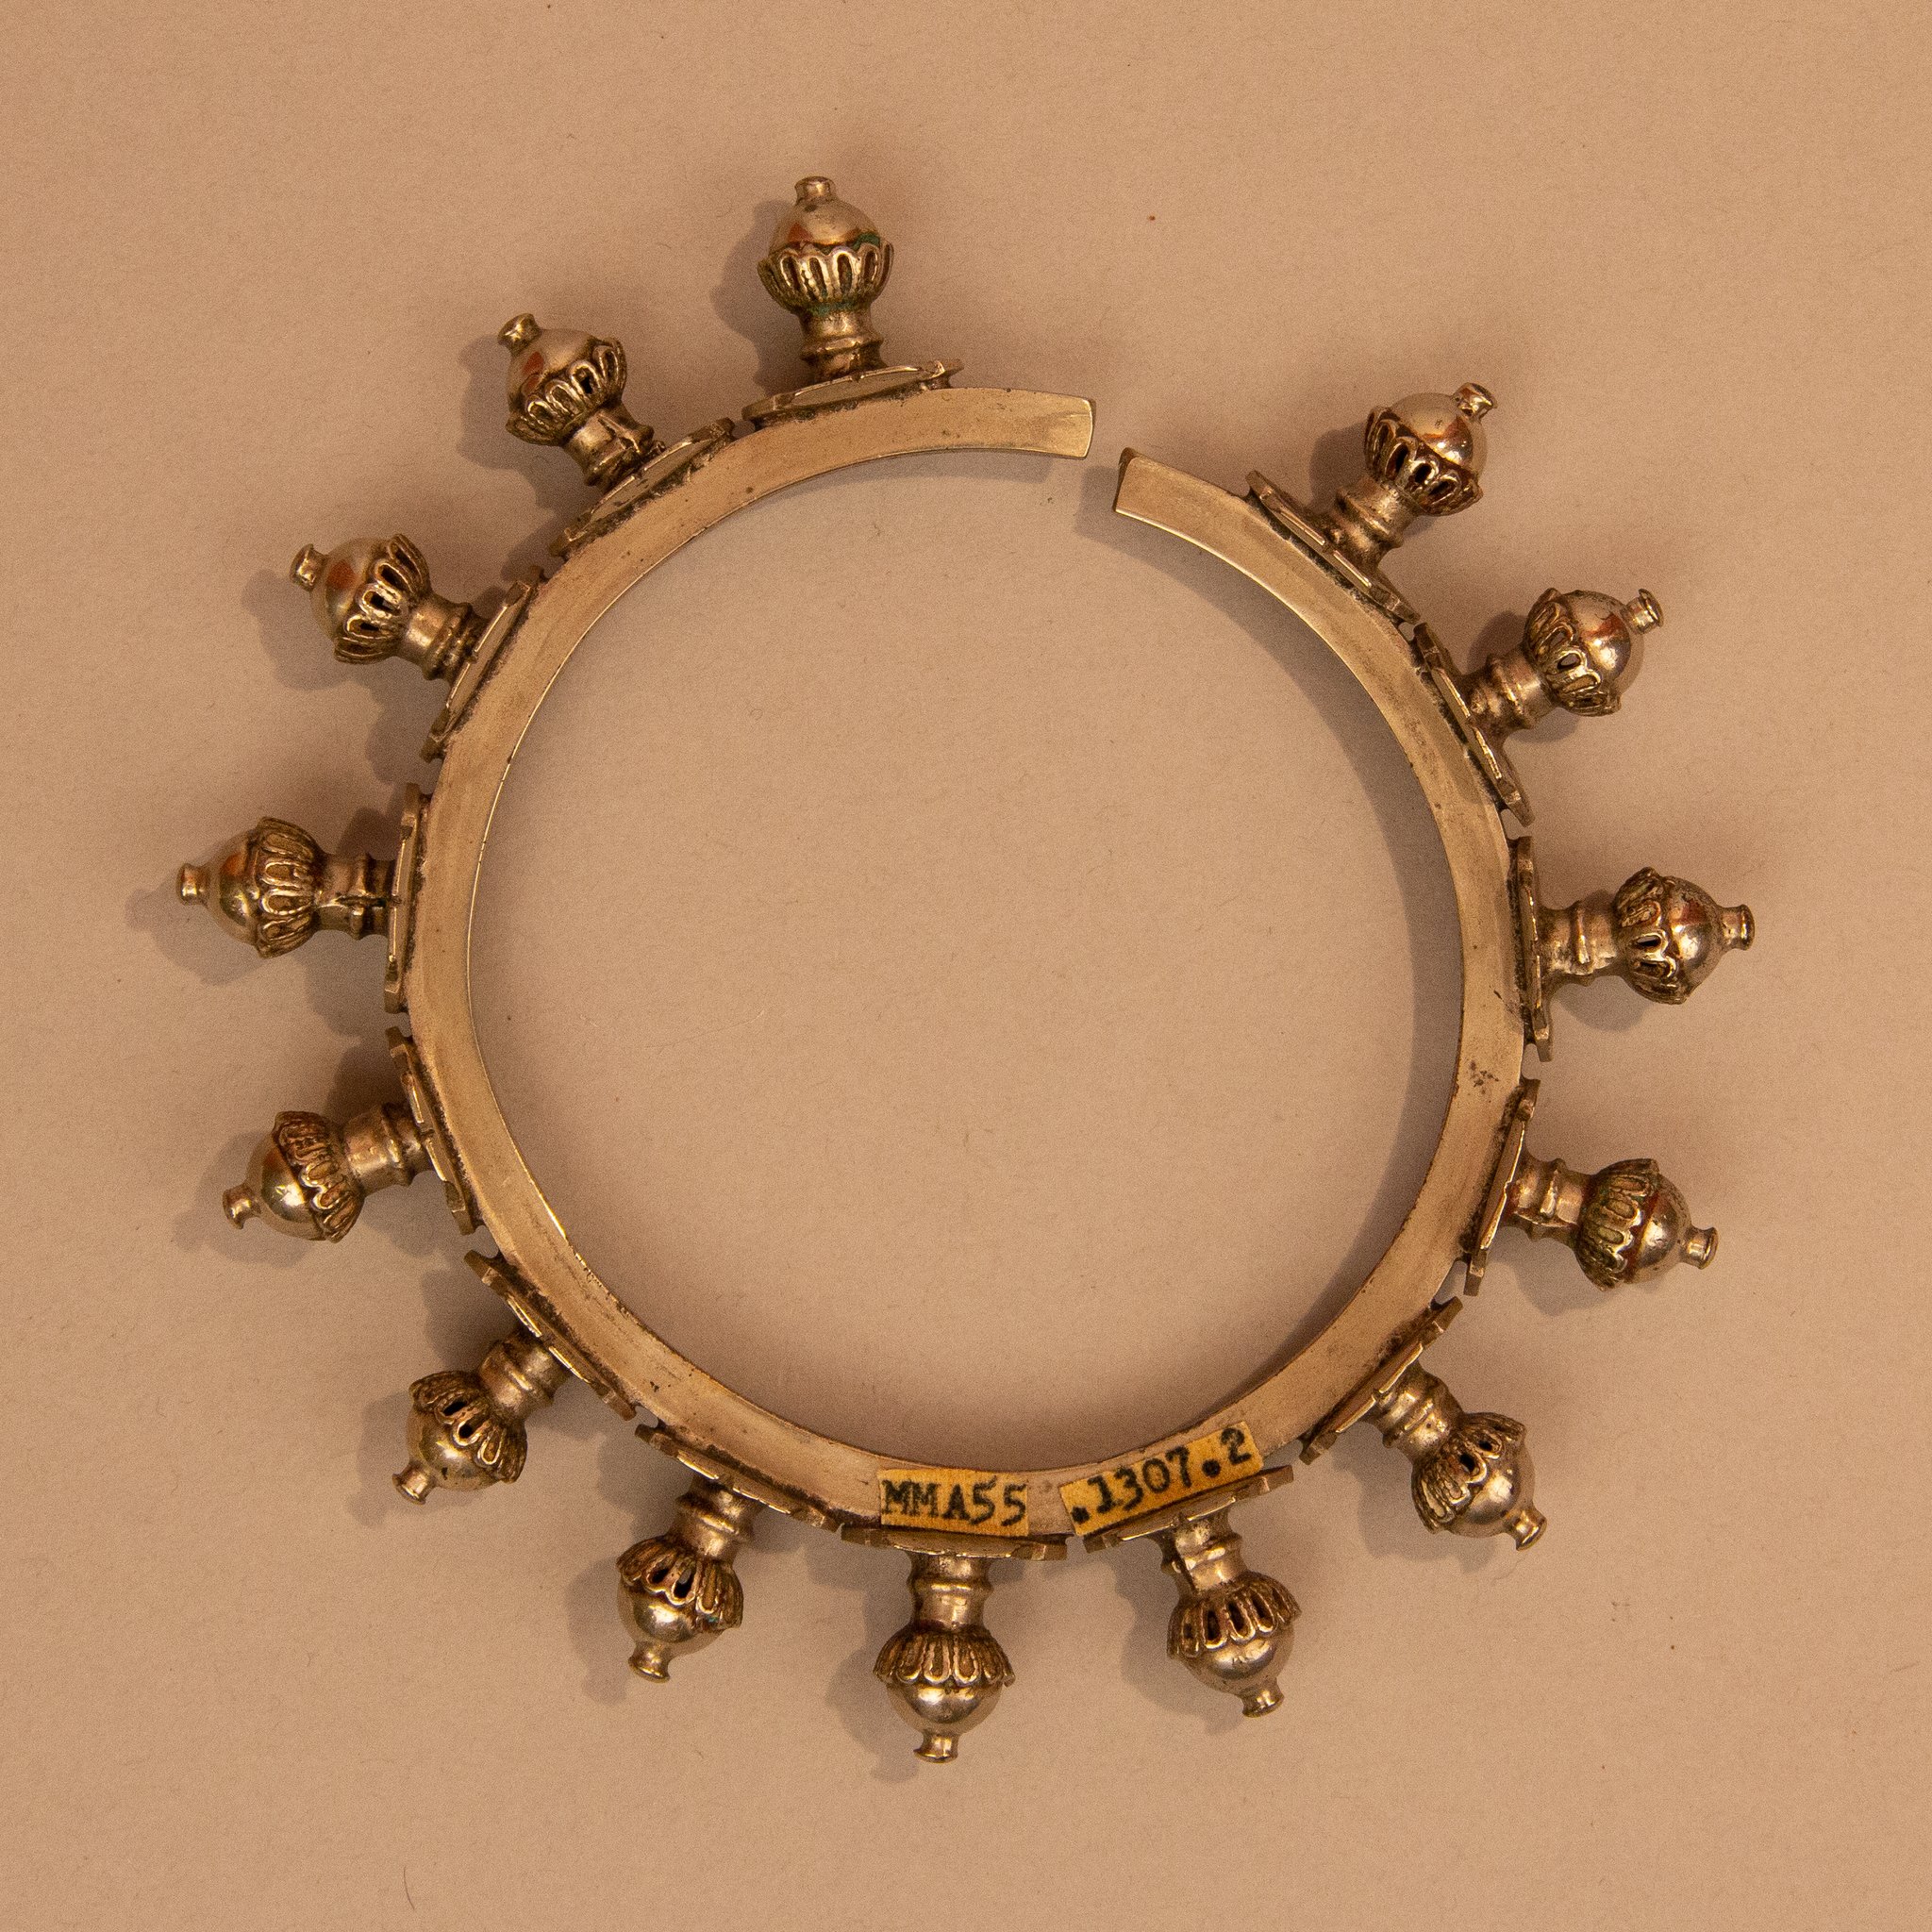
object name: bracelet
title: Bracelet, One of a Pair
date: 1801-1900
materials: silver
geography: india